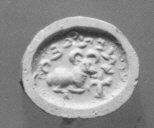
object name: stamp seal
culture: sasanian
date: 301-400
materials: gemstone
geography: iran or mesopotamia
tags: animals